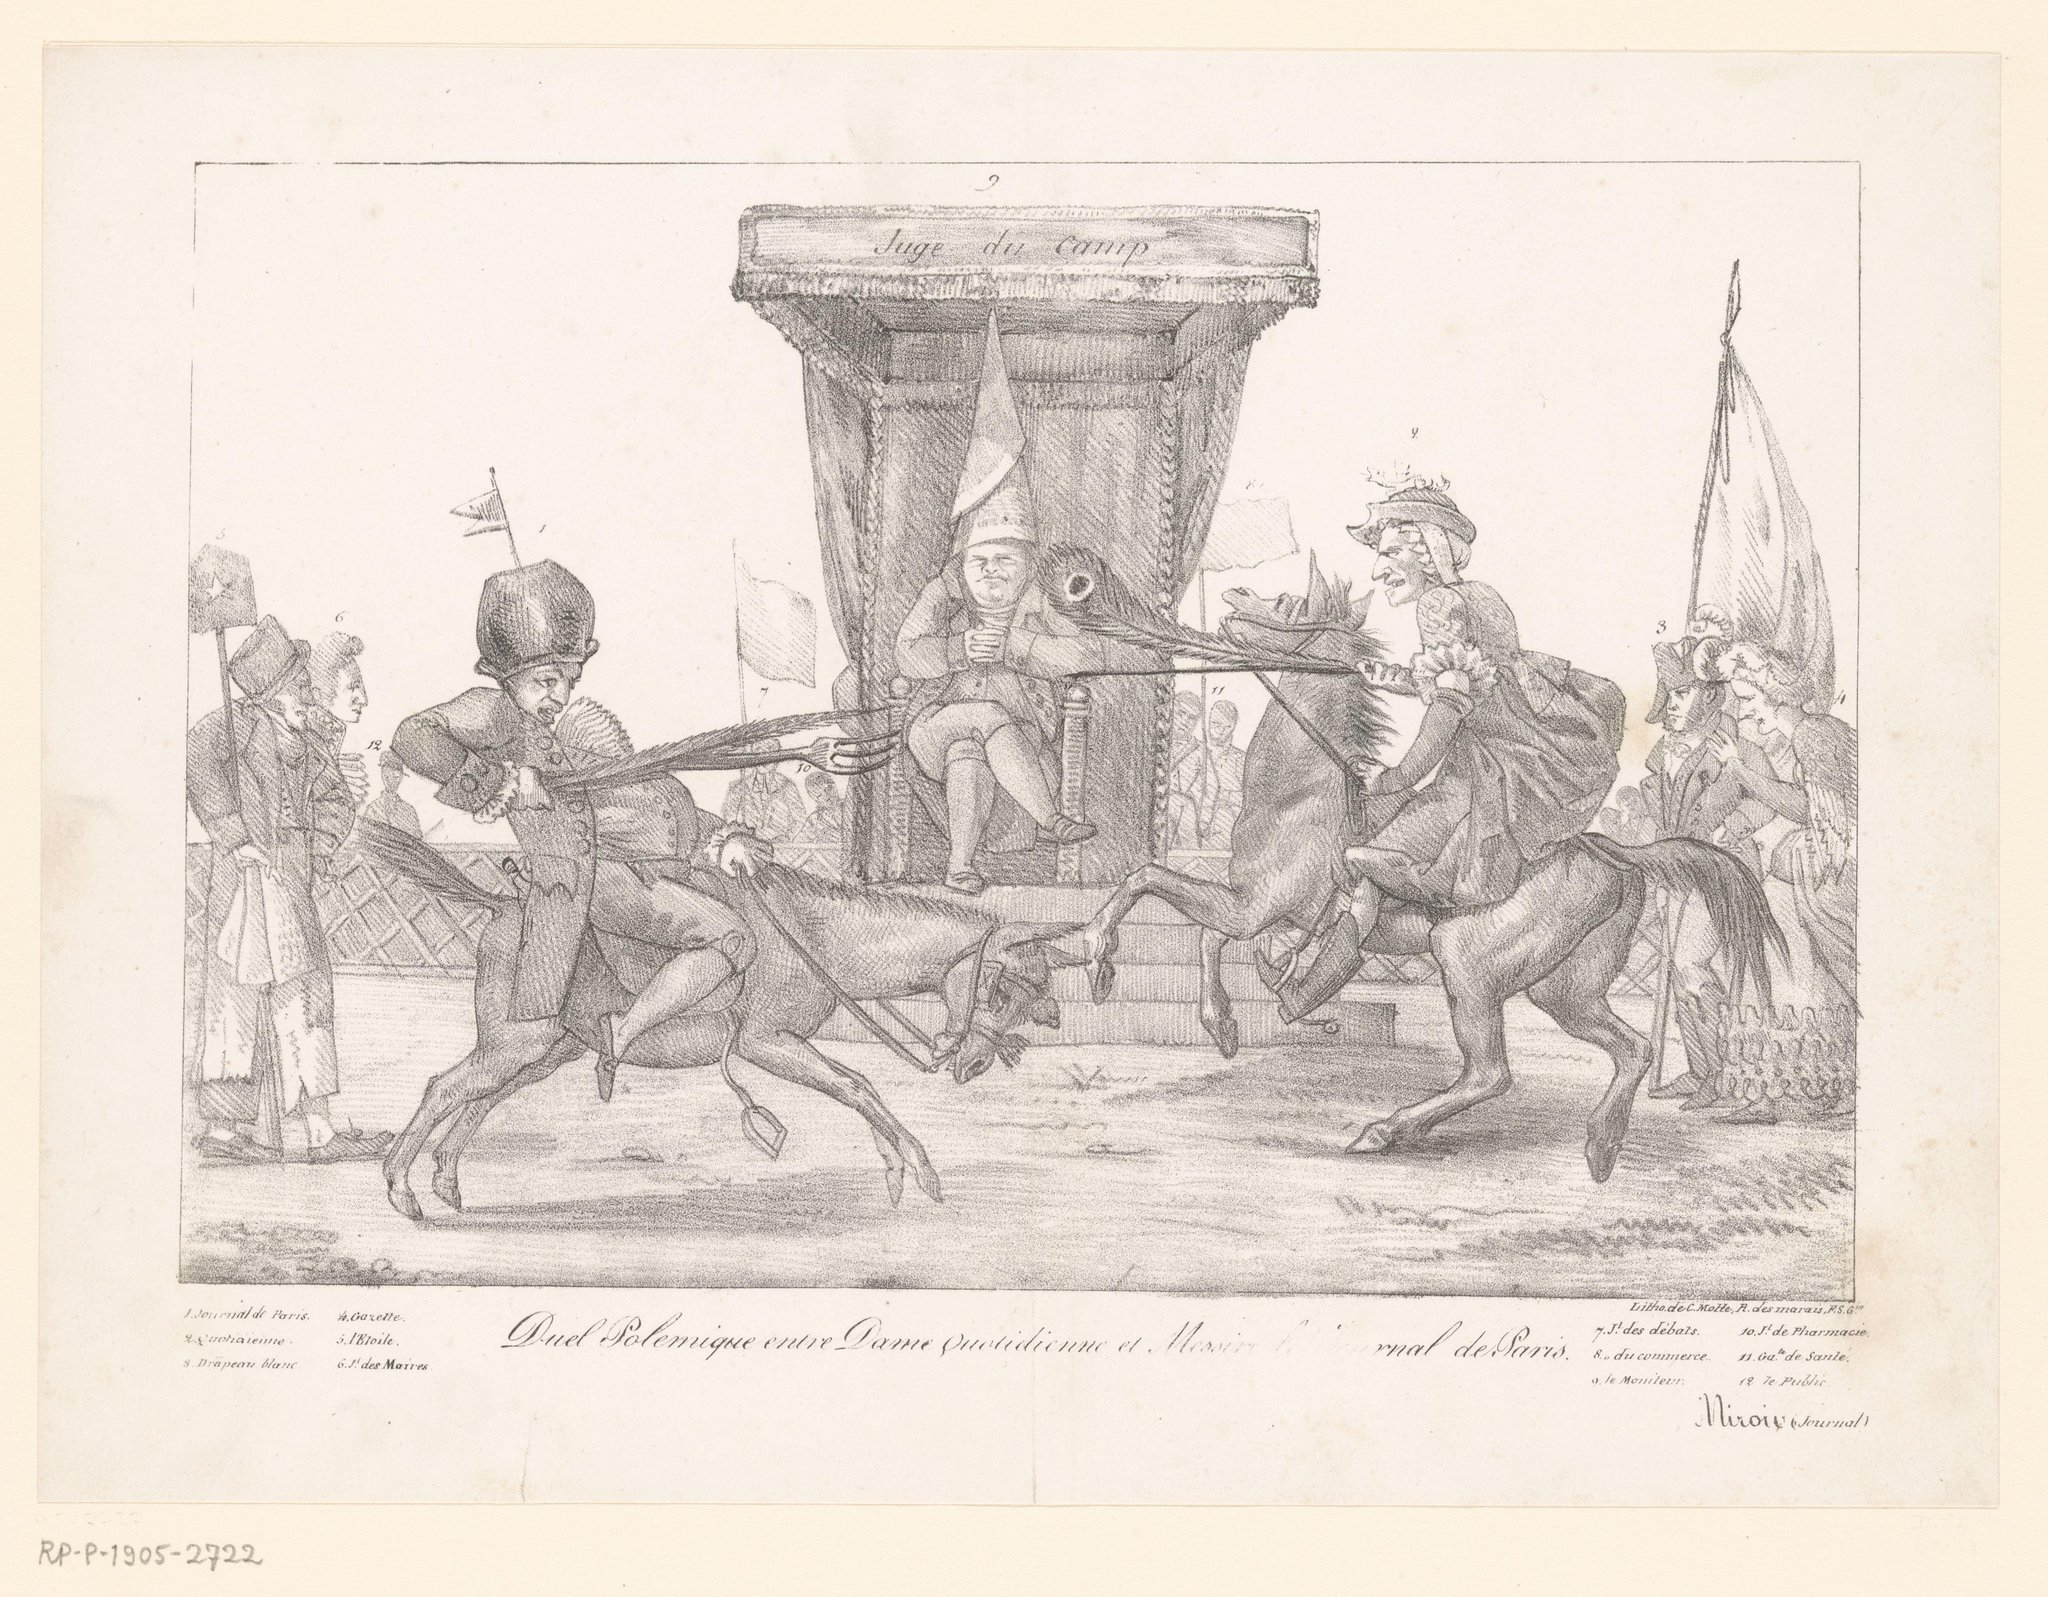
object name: cartoon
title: Gevecht tussen twee allegorische figuren op ezels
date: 1821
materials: paper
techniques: lithograph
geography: paris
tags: duelling, political caricatures and satires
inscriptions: collector's mark: Lugt 2228a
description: Prent gebruikt in: Le Miroir des spectacles, des lettres, des mœurs et des arts 1 (1821), nr. 228, 29 september 1821.